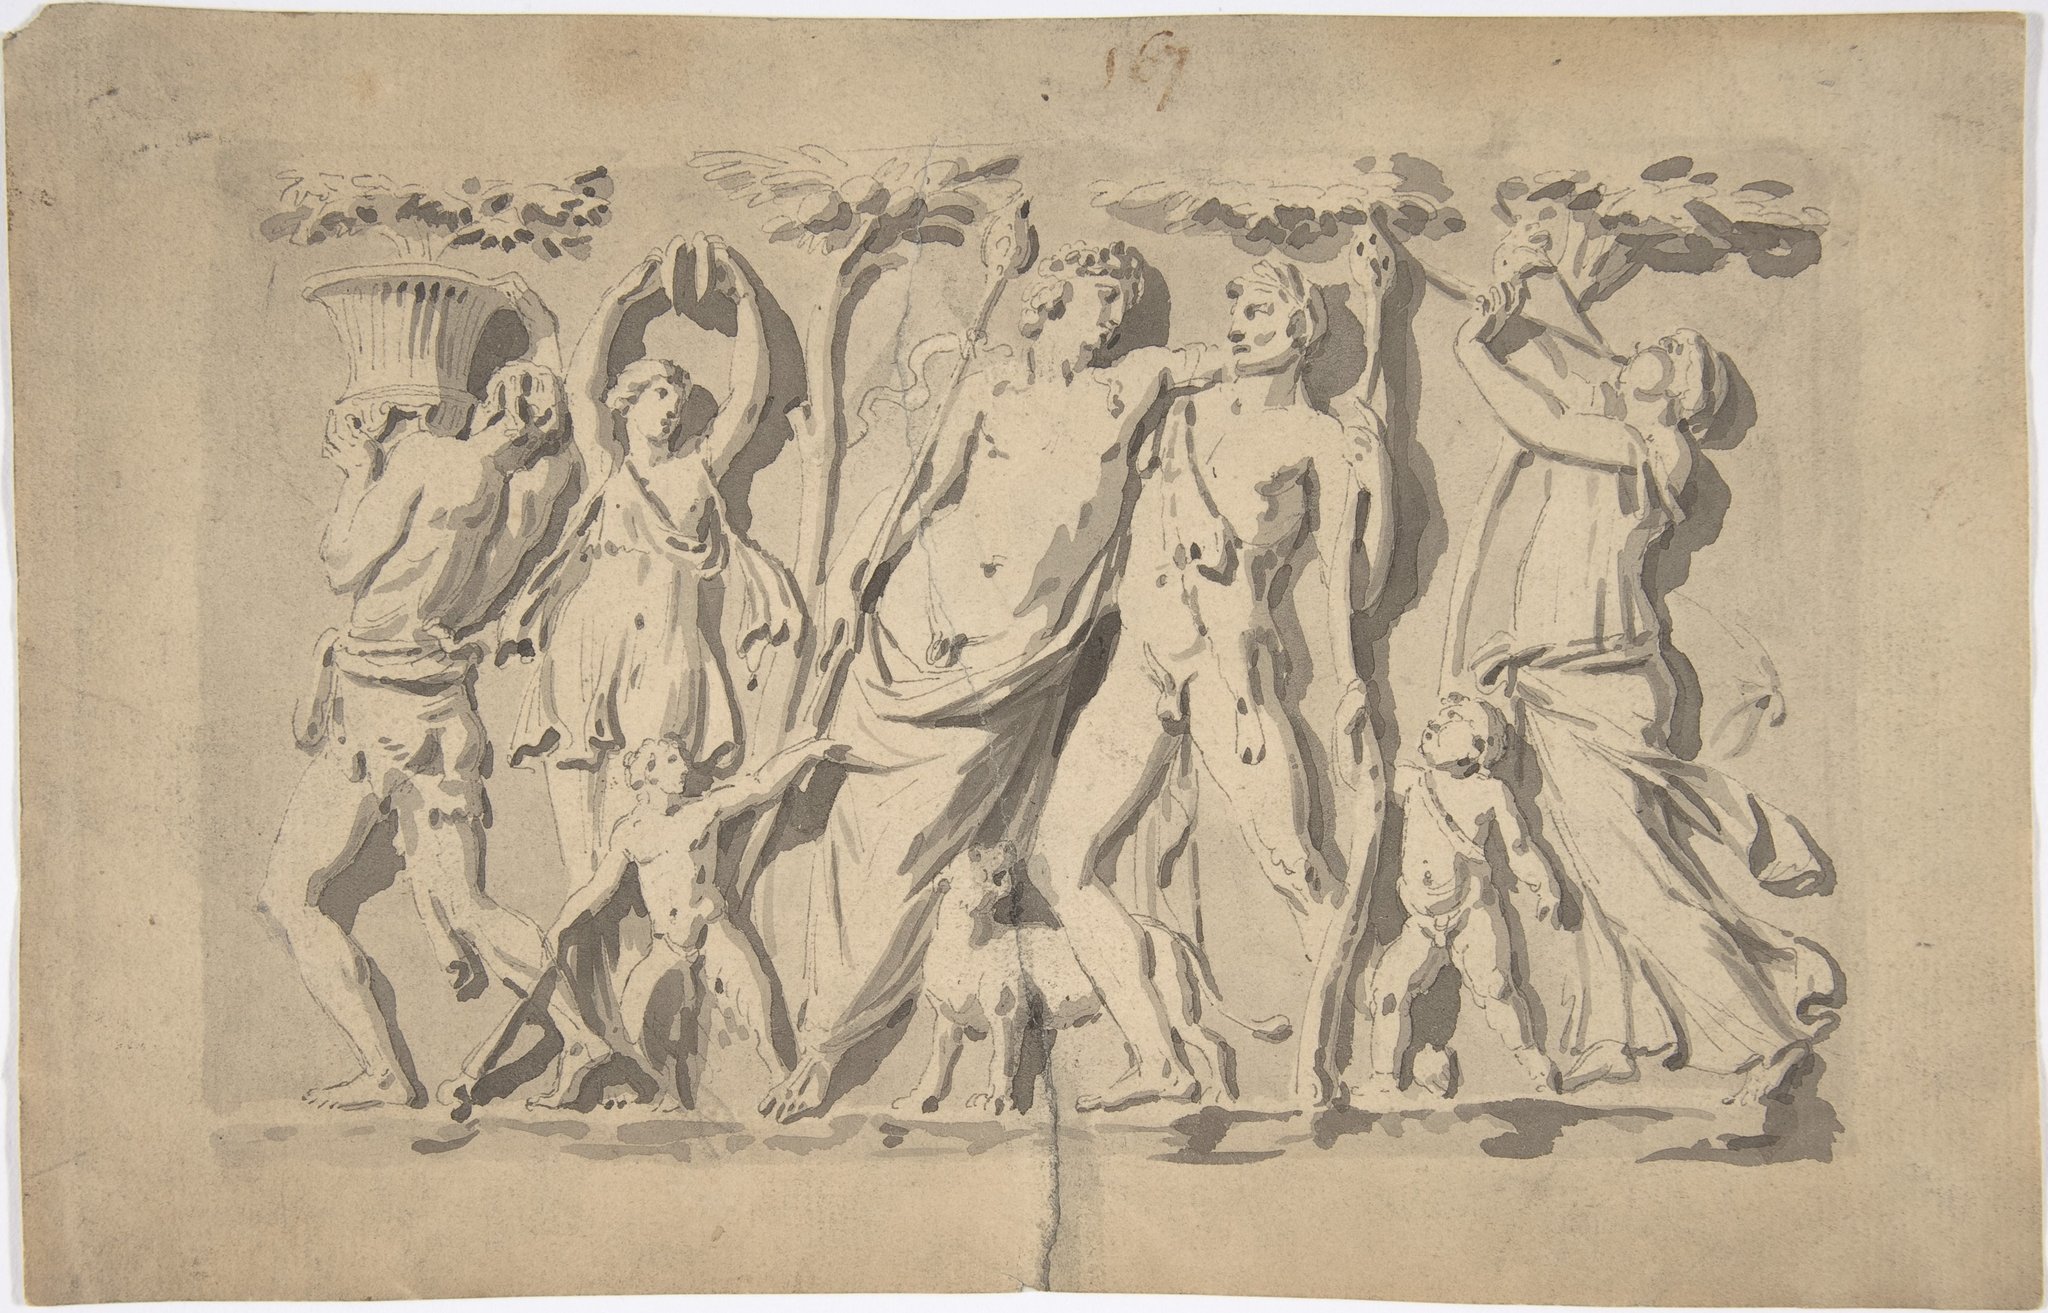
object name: drawing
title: Bacchanal Scene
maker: anonymous, french, 18th century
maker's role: artist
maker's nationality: french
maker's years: 1700-1800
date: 1701-1800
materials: ink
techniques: brush, pen, wash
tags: male nudes,female nudes,dogs